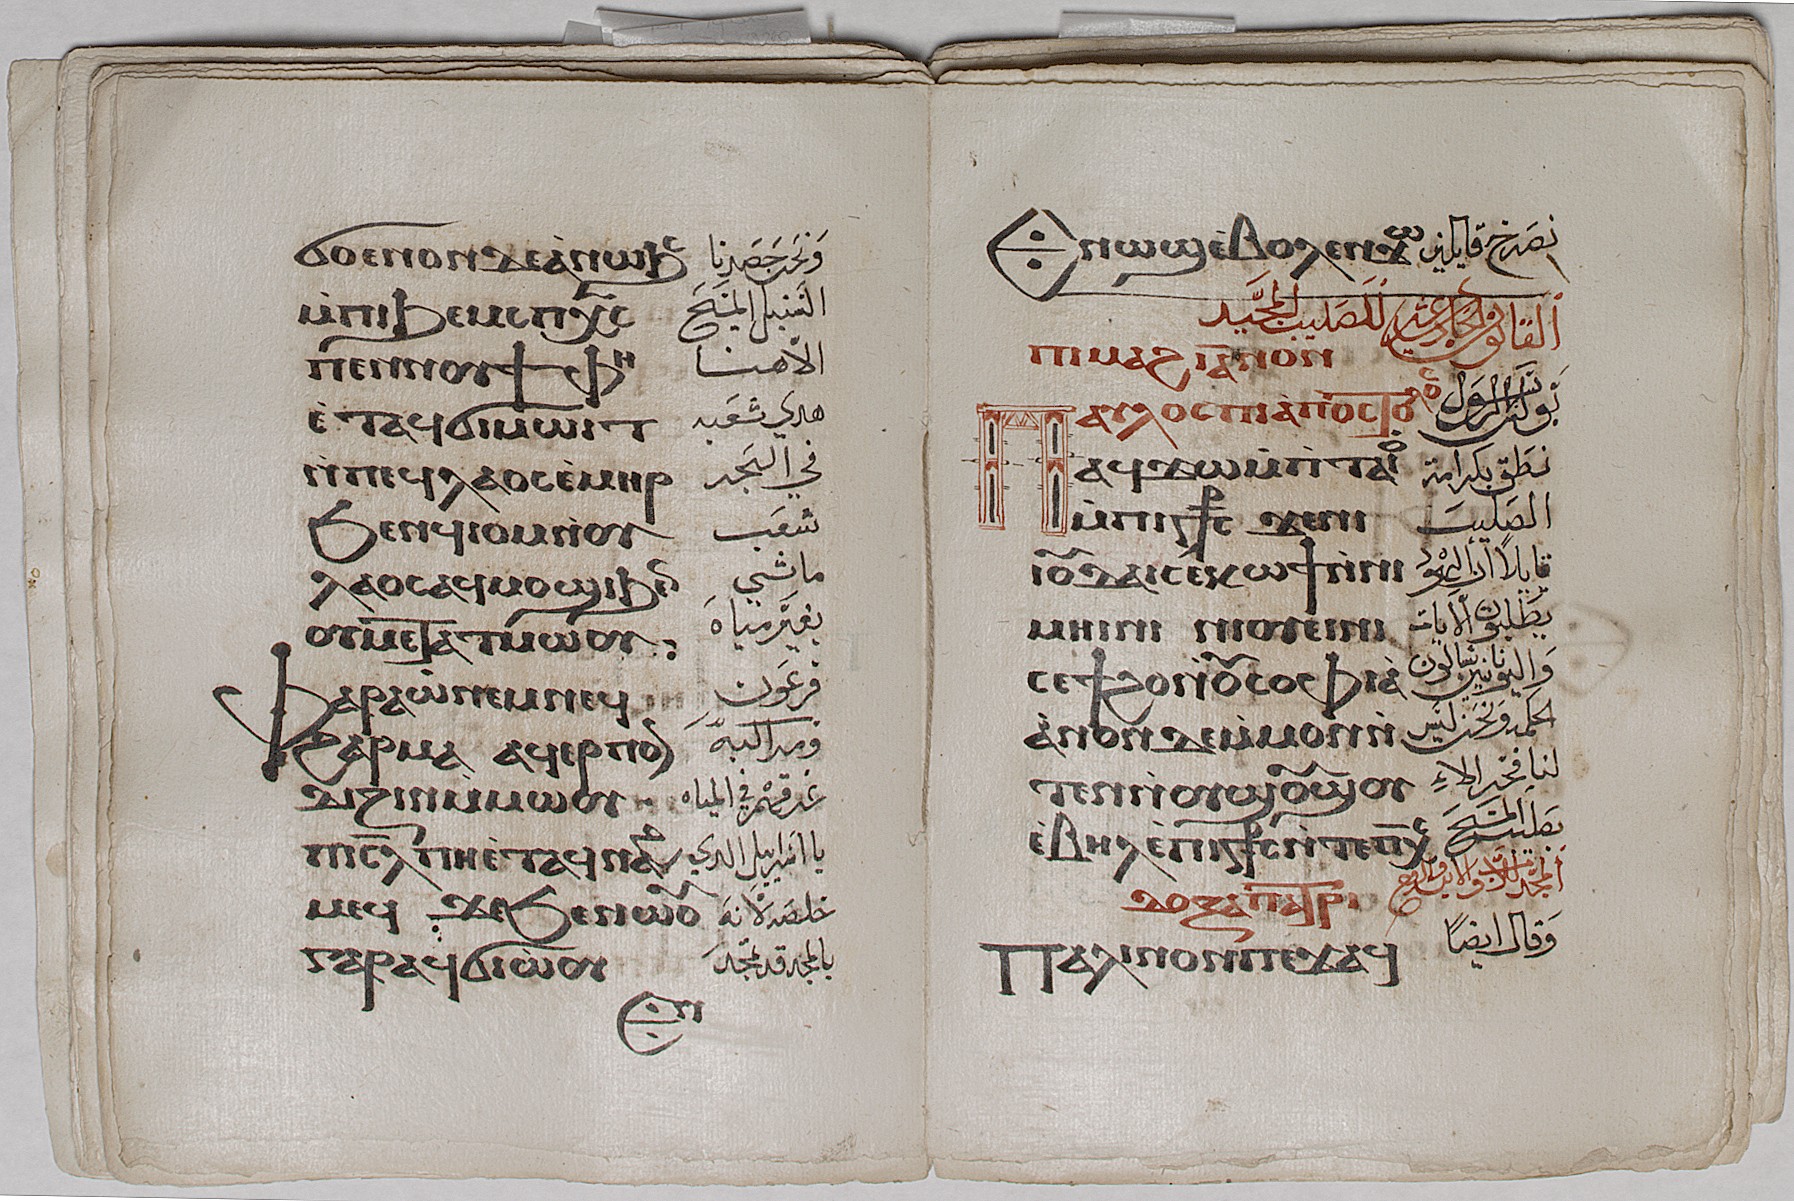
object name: non illustrated manuscript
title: Copto-Arabic Book of Prayers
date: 1601-1800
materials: ink, paper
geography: egypt